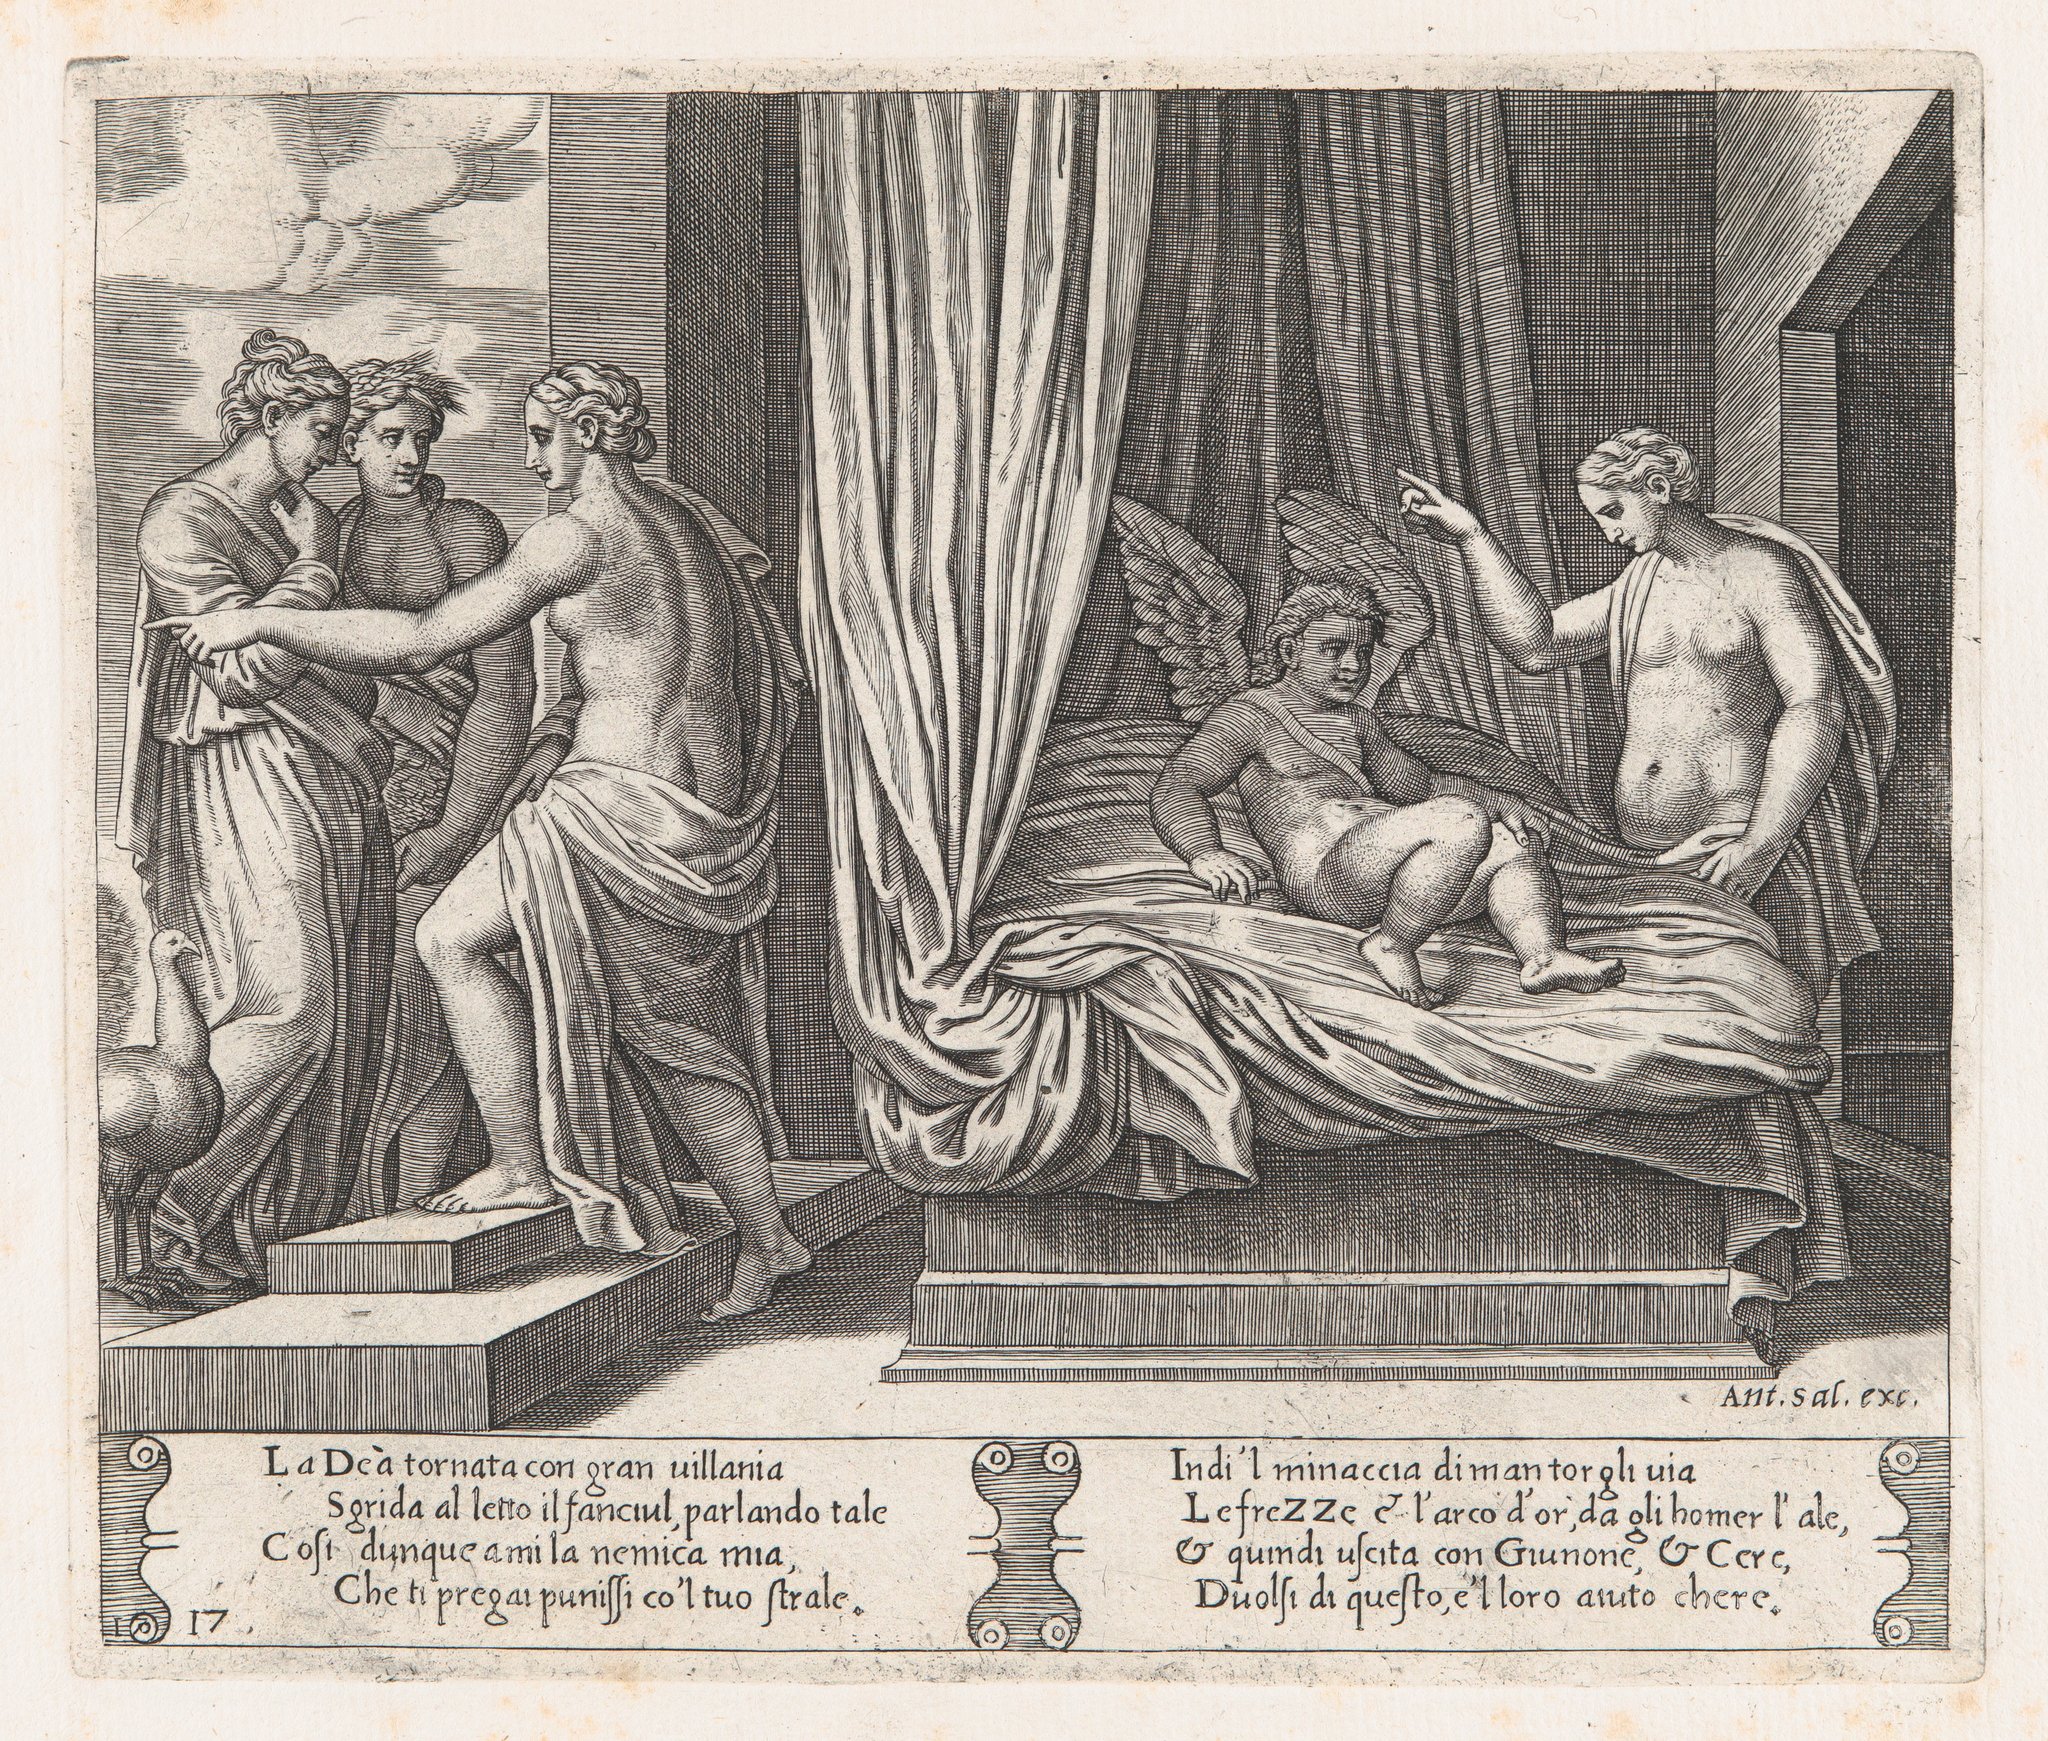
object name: print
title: Plate 17: Venus chastising Cupid, who sits on a bed, with Psyche at right, from "The Story of Cupid and Psyche as told by Apuleius"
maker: master of the die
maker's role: artist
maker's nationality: italian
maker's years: 1525-1560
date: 1530-1560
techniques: engraving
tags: cupid,psyche,venus